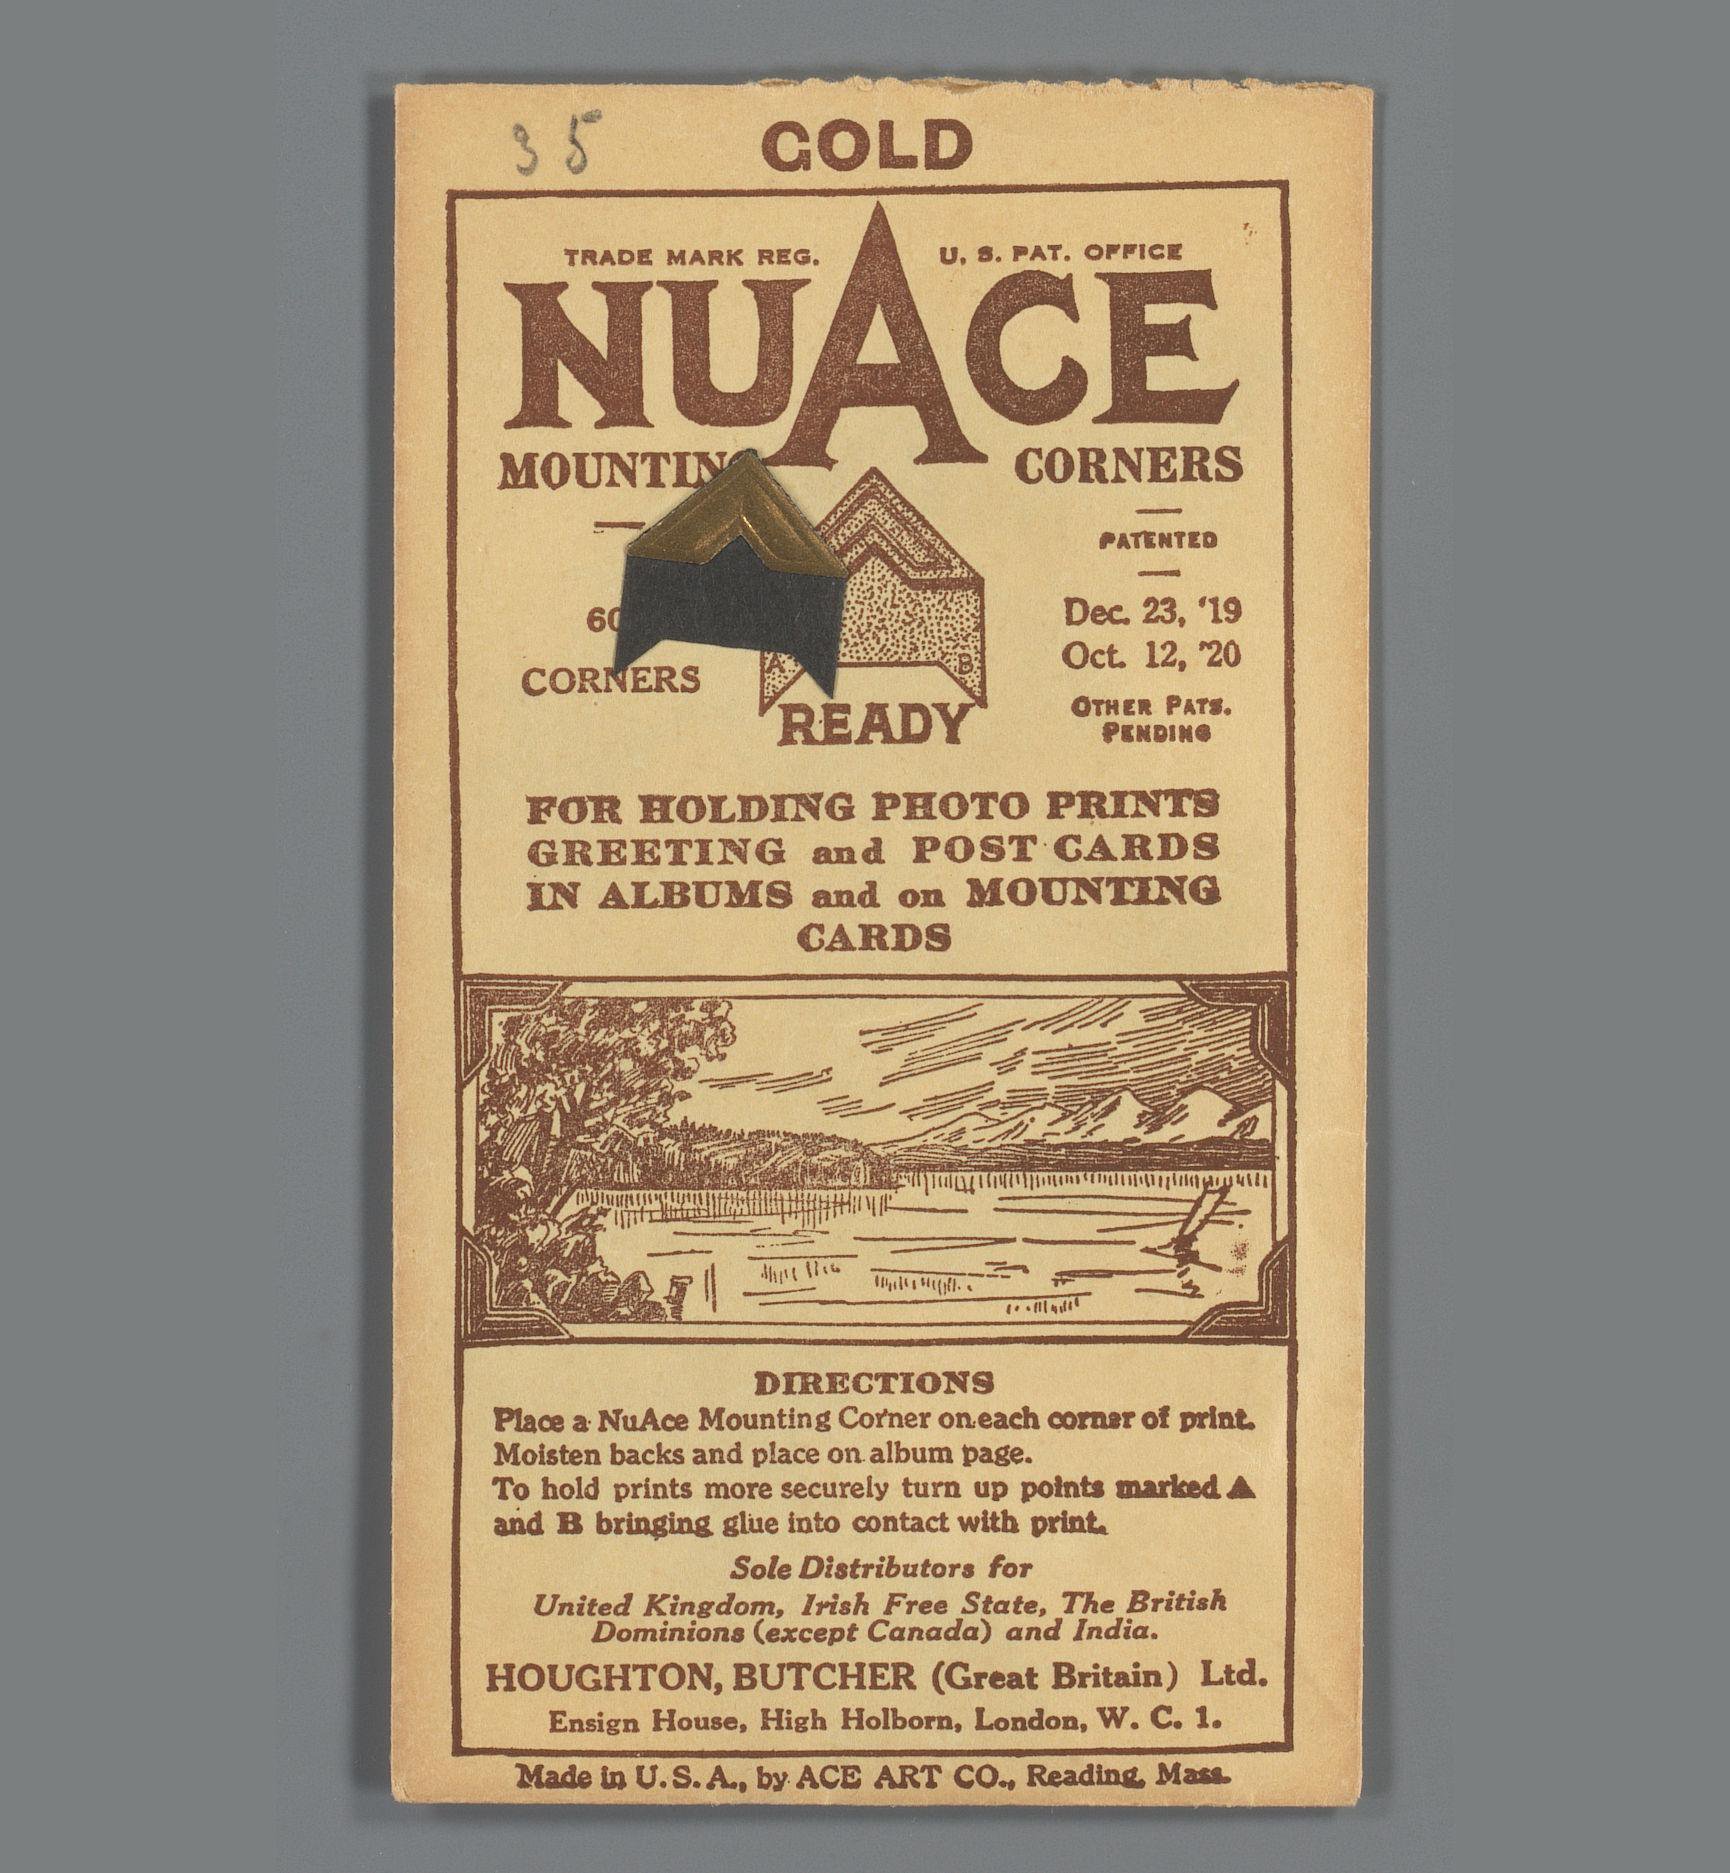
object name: document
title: Zakje met fotohoekjes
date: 1920-1940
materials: paper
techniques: lithograph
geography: reading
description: Zakje met fotohoekjes van het merk Nuace Mounting Corners, type Gold.